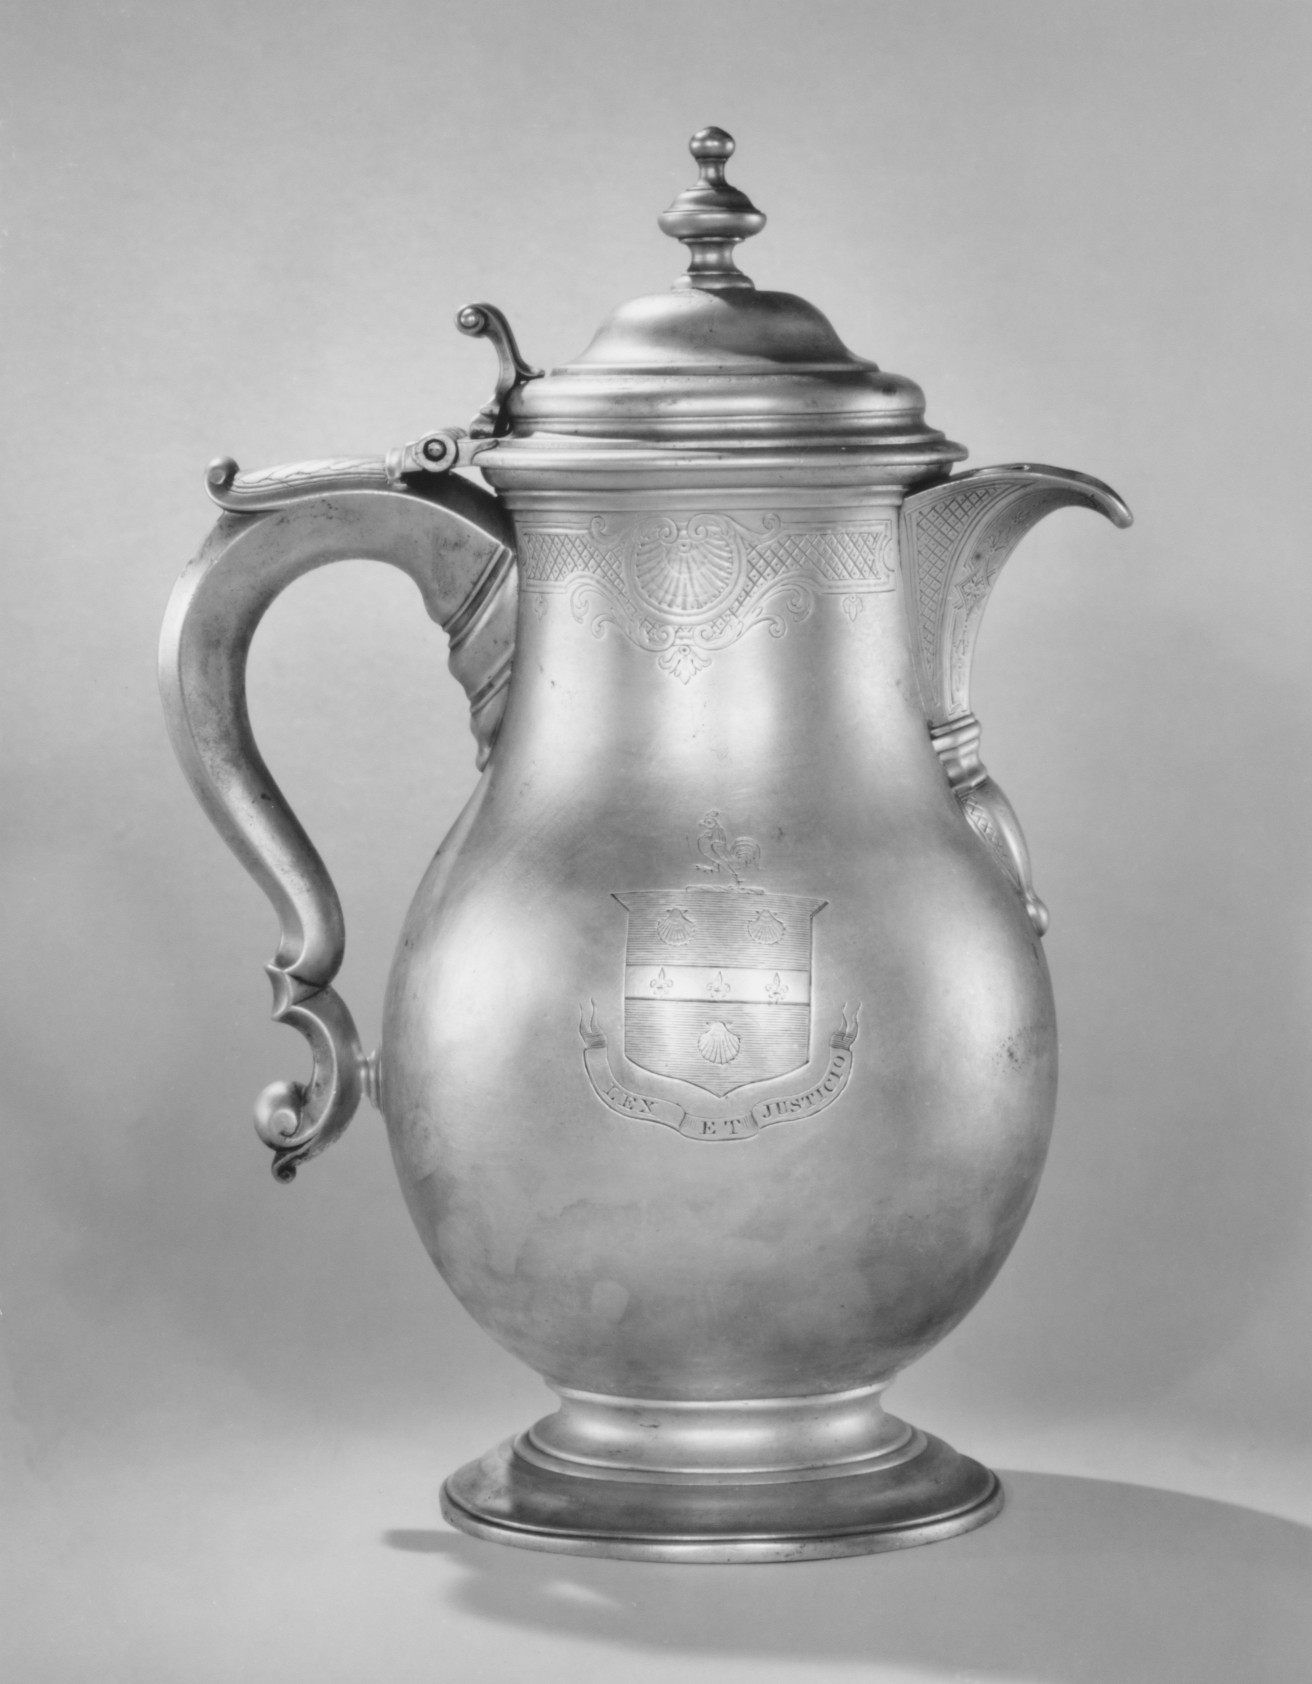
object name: jug with cover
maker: paul de lamerie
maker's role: maker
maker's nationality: british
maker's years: 1688-1751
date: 1729-1730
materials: silver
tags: coat of arms